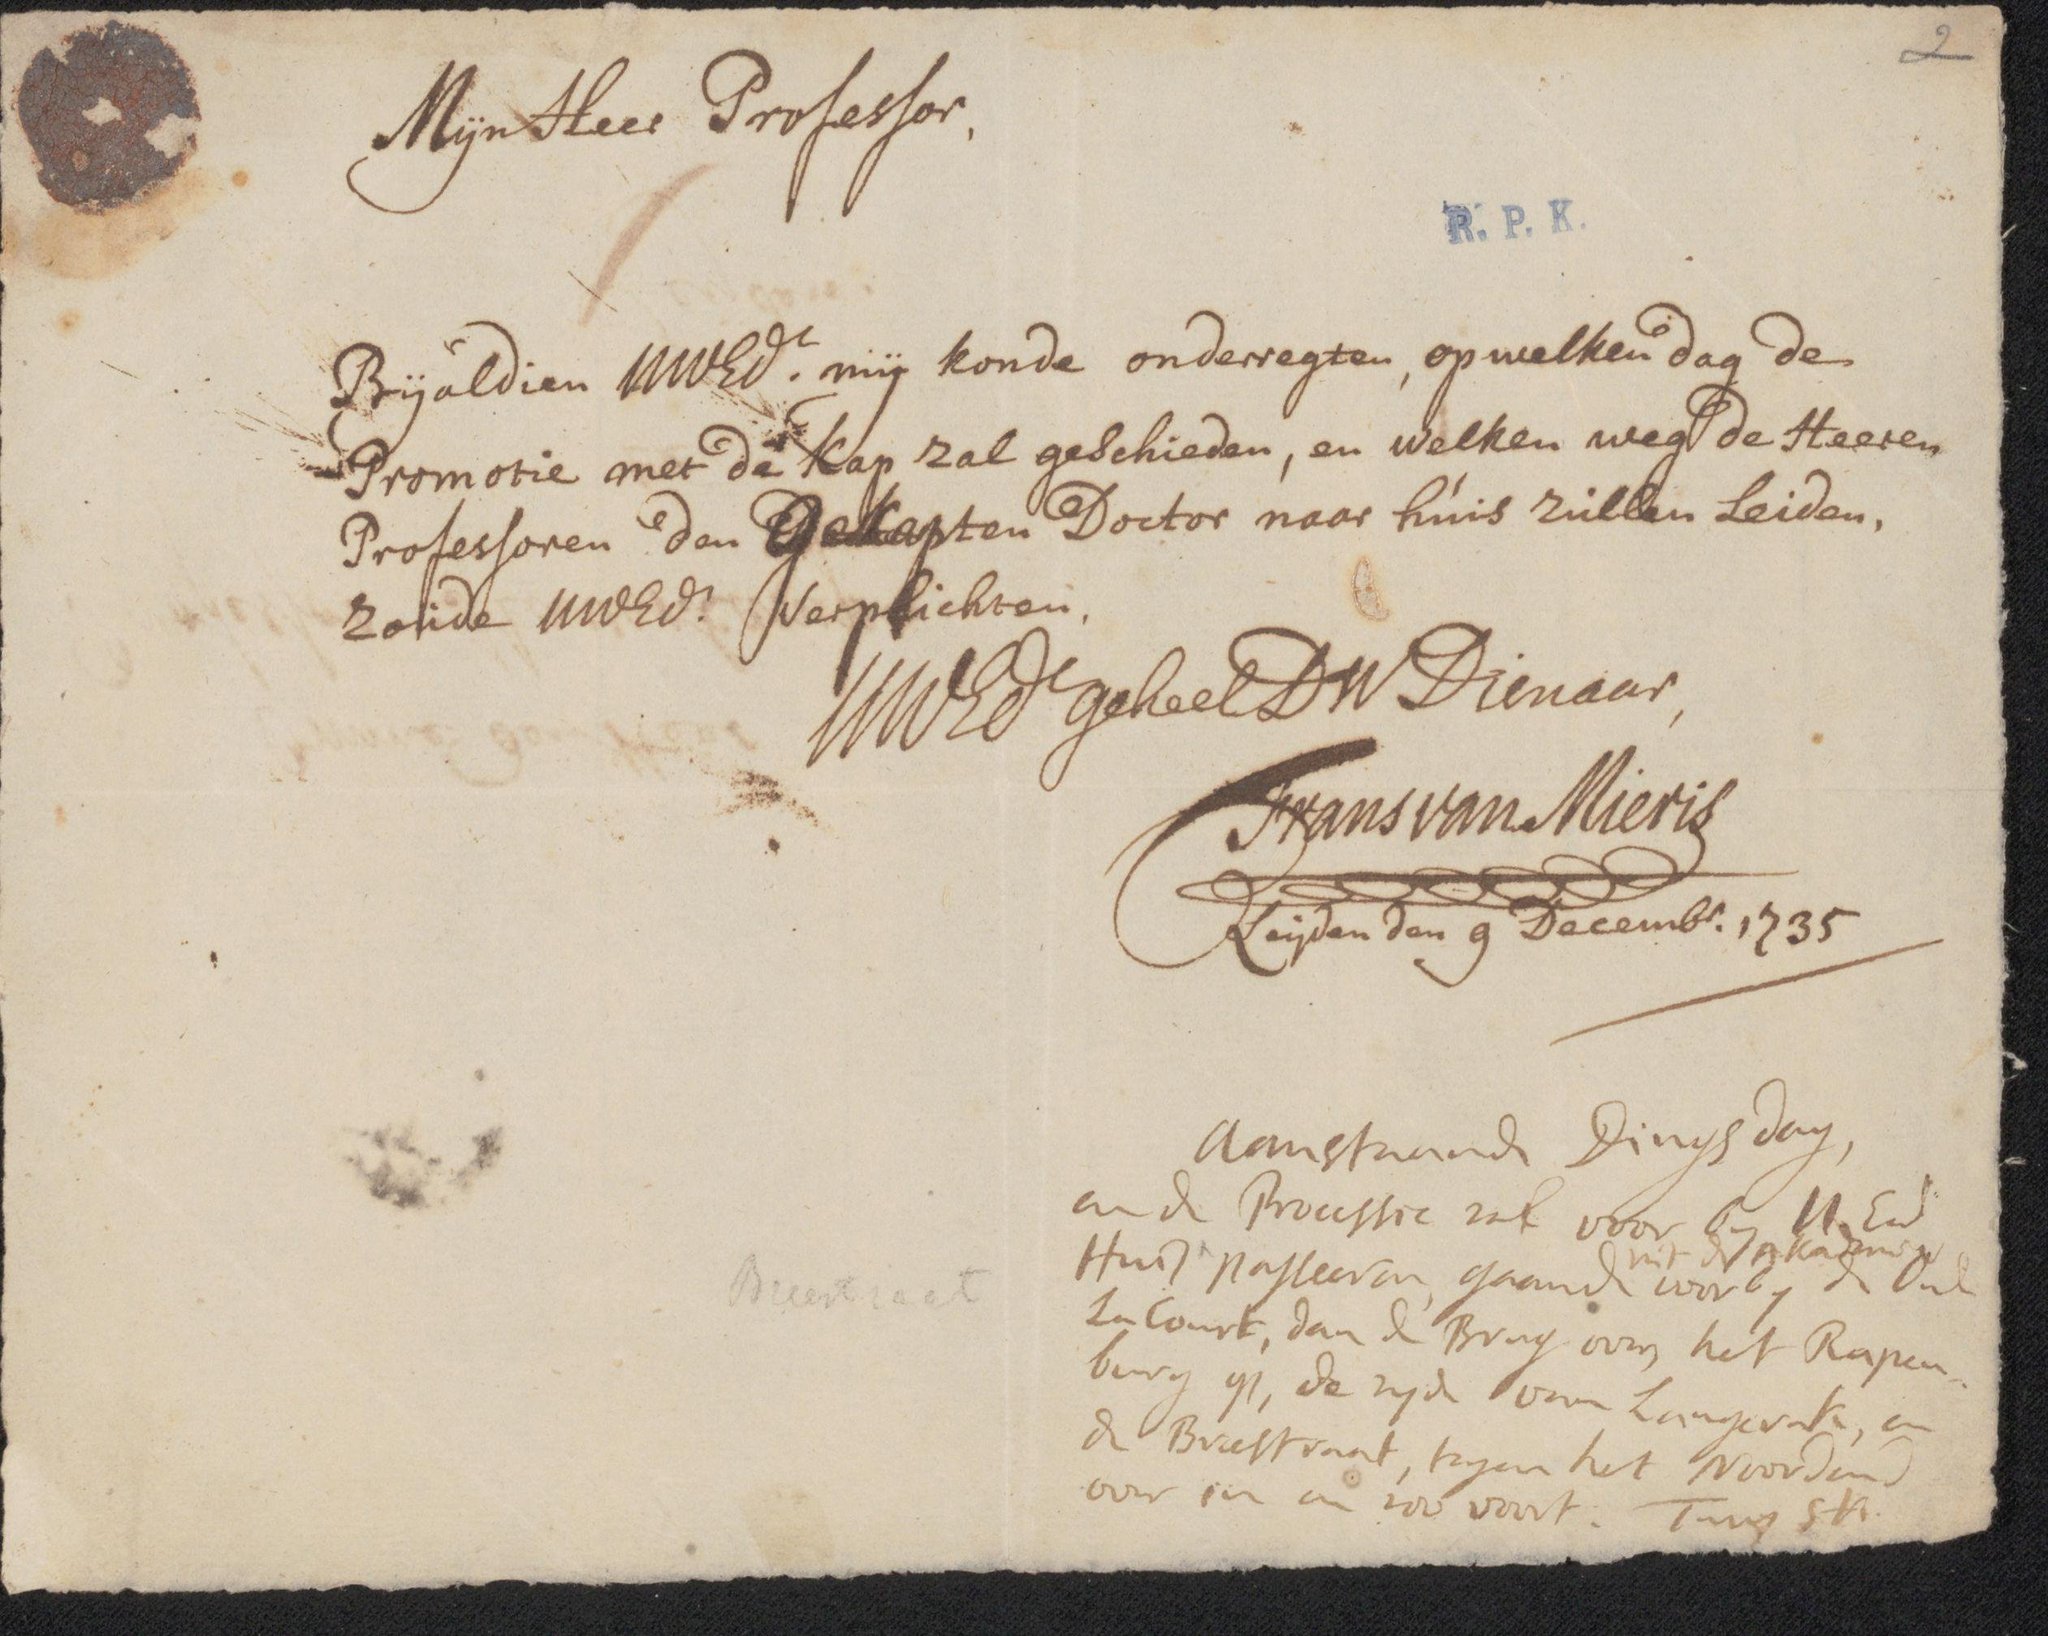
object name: letter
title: Brief aan Siwert Haverkamp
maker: frans van mieris (ii)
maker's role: draughtsman, painter, print maker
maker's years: 1689-1763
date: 1735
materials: ink, paper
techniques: pen, writing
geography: leiden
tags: leiden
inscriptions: collector's mark: Lugt 2233